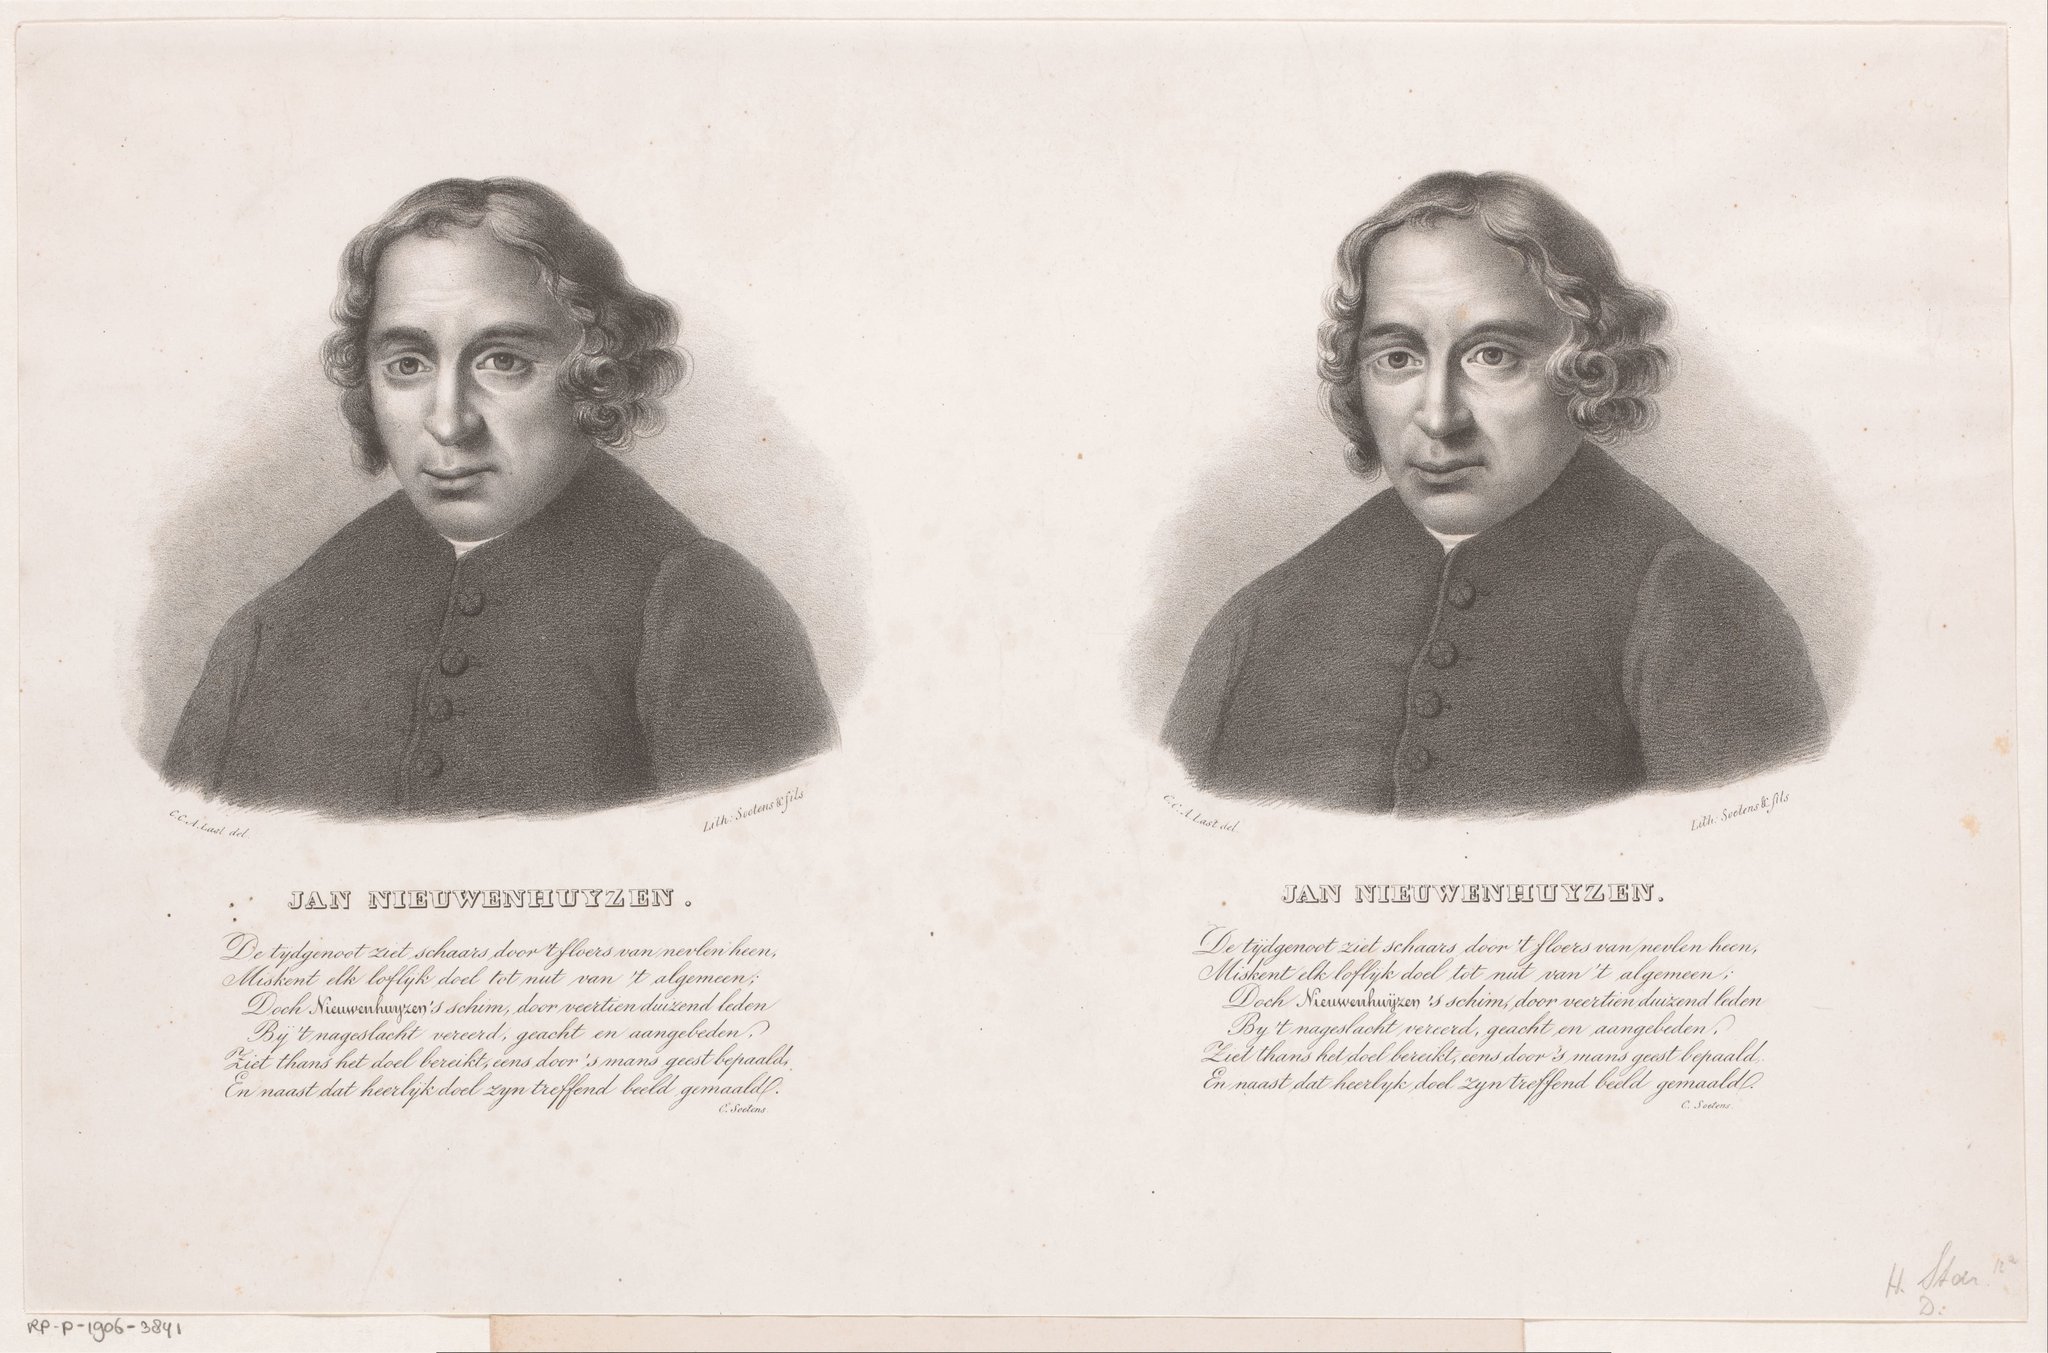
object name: print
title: Twee portretten van Jan Nieuwenhuyzen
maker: carel christiaan antony last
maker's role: print maker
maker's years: 1808-1876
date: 1837-1840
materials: paper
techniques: lithograph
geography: the hague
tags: haarlem, jan nieuwenhuyzen, historical persons (+ (full) bust portrait)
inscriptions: collector's mark: Lugt 2228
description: Onder ieder portret zijn naam en een zesregelig onderschrift door C. Soetens.